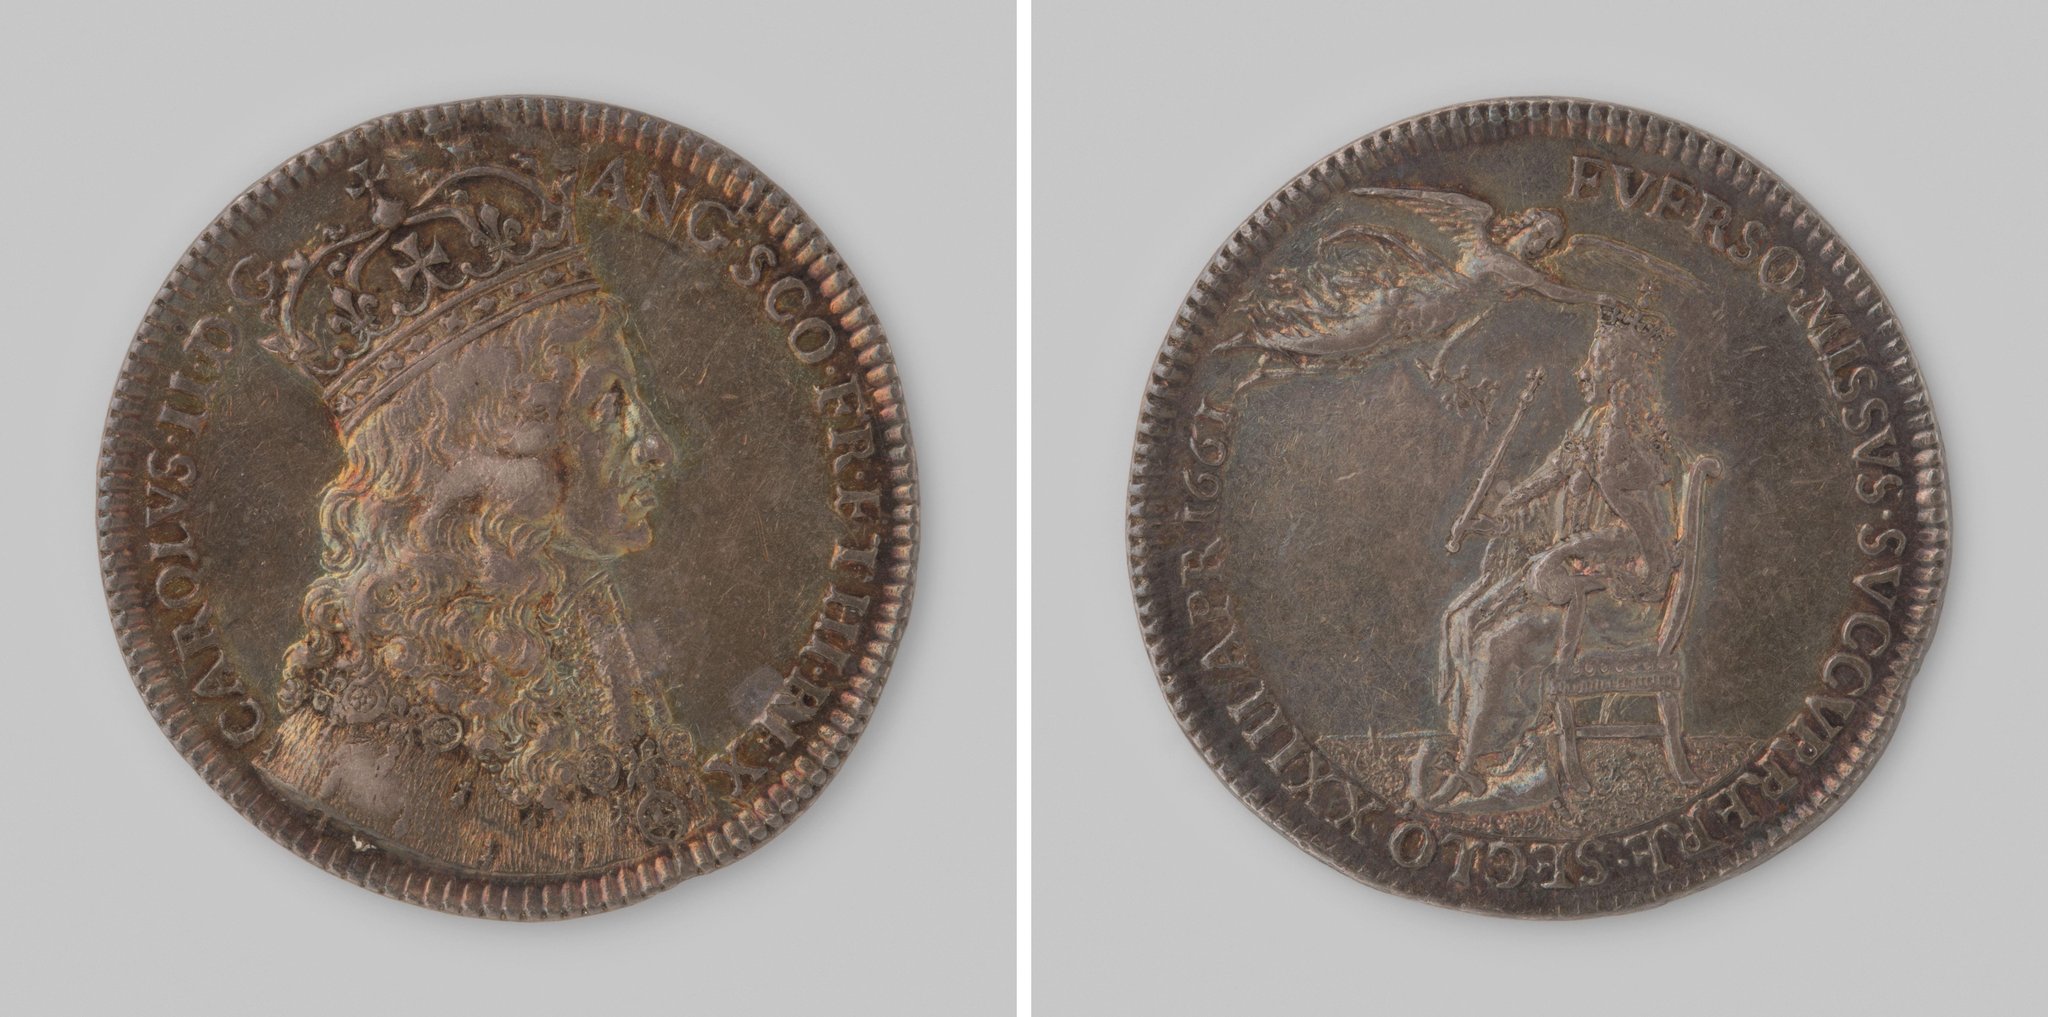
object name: history medal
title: Kroning van Karel II van Engeland 1661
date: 1661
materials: silver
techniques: striking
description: Zilveren penning, op de voorzijde het gekroonde borstbeeld bvan Karel II met omschrift, op de keerzijde de getroonde vorst in vol ornaat gekroond door een zwevende Victoria met olijftak, met omschrift.